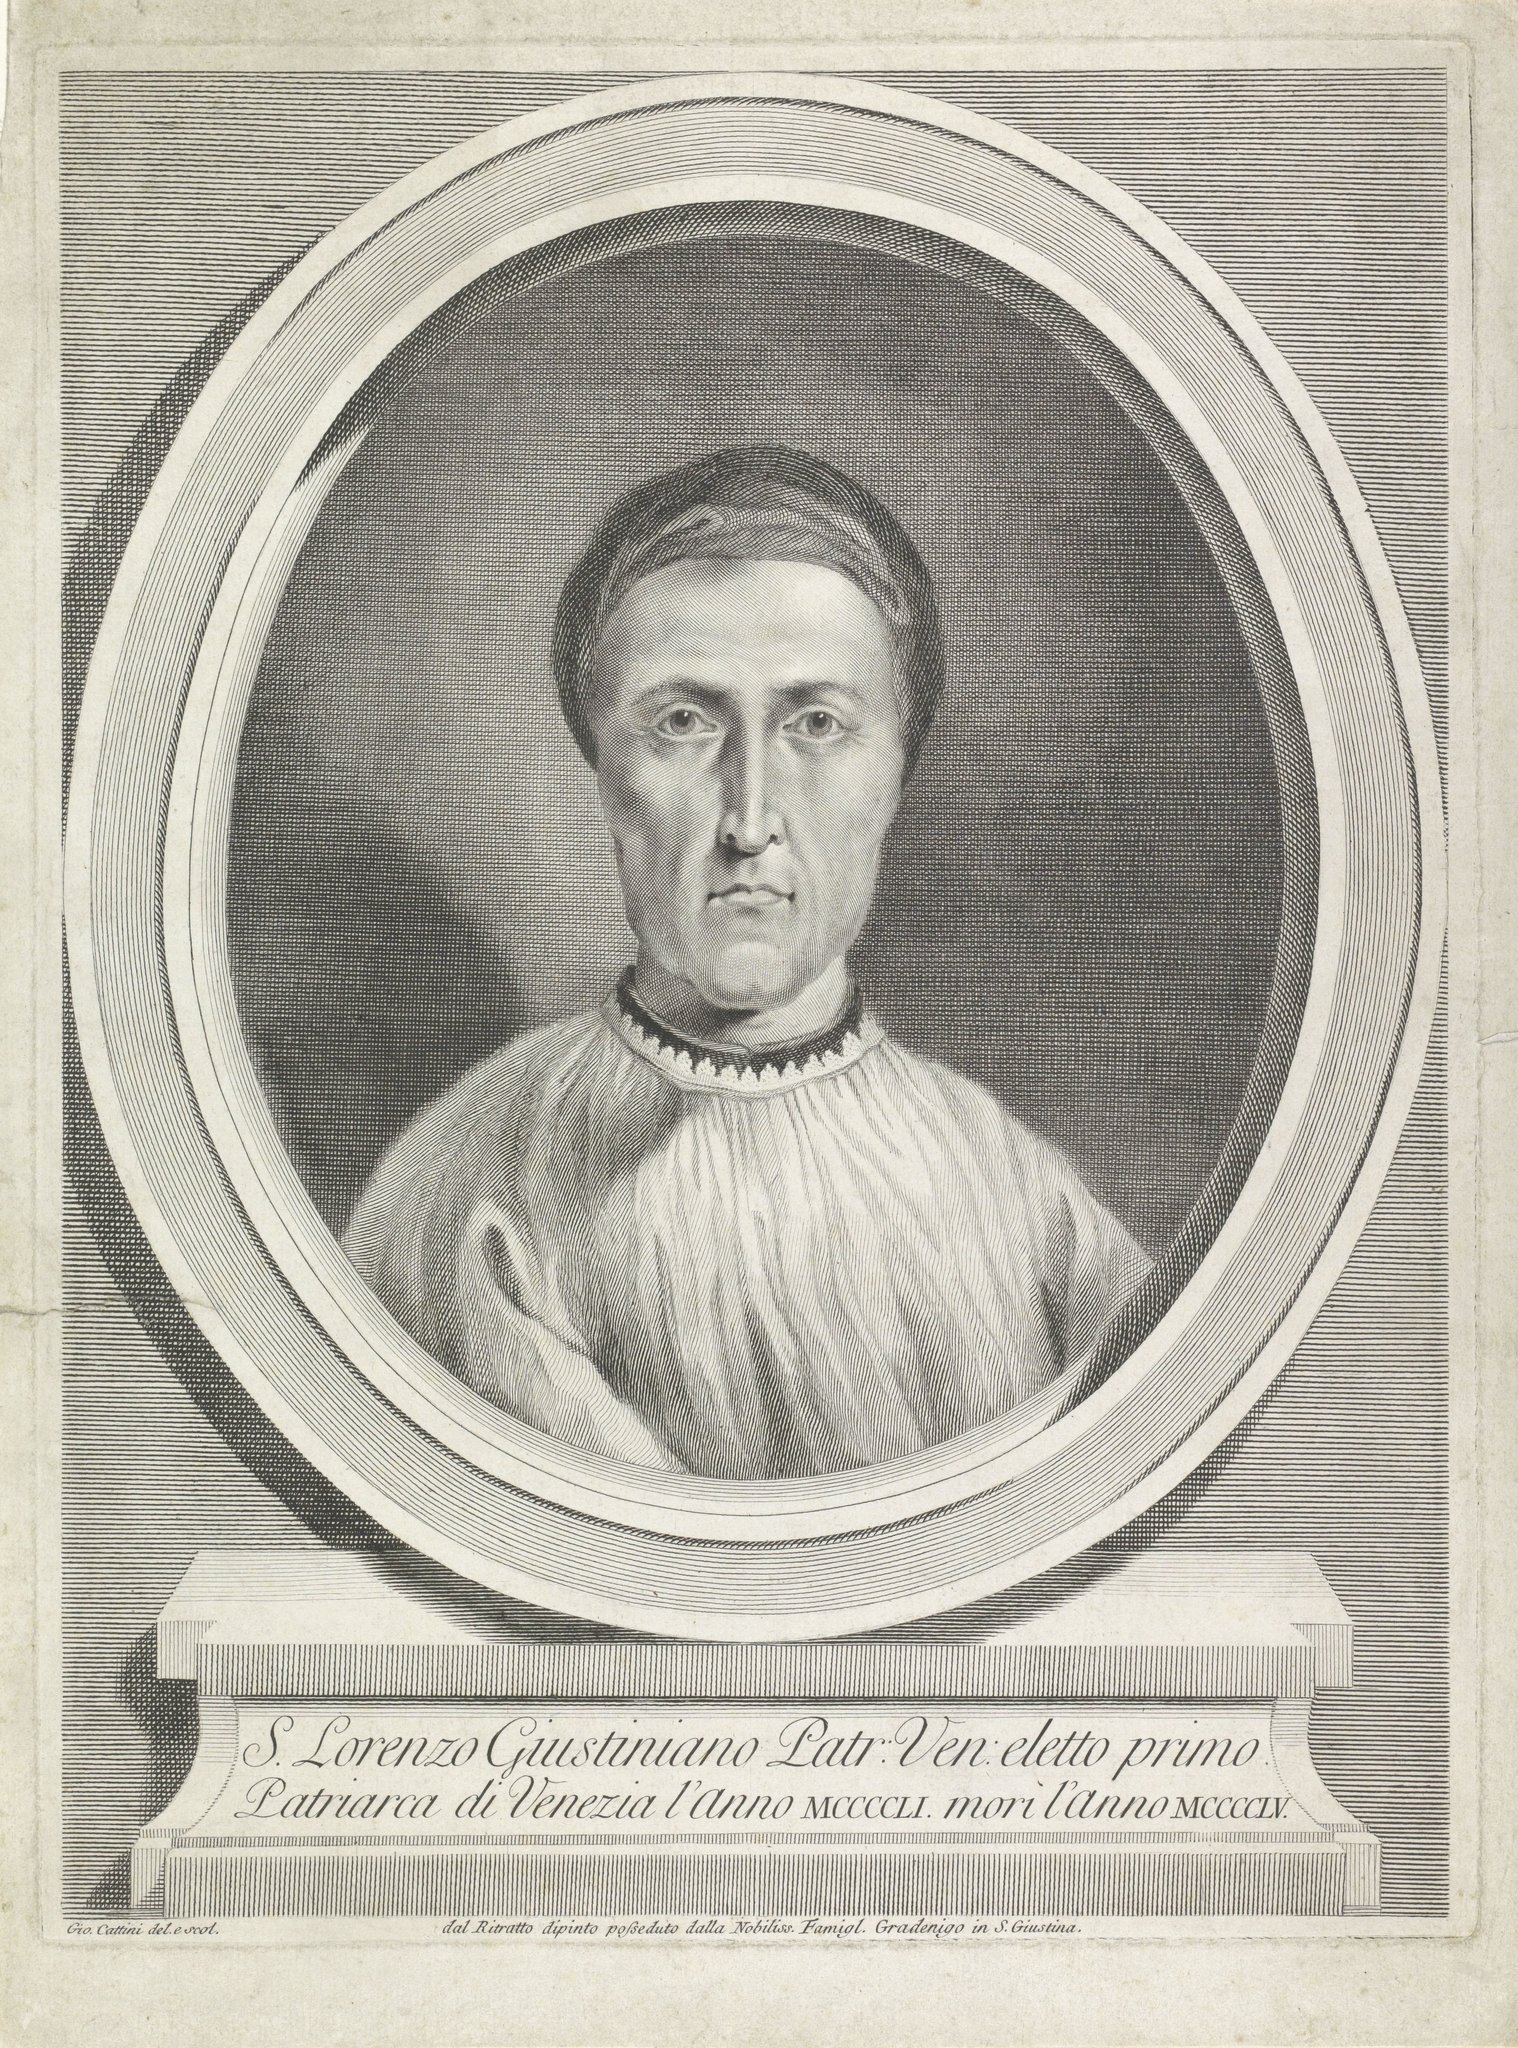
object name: print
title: Portret van Lorenzo Giustiniani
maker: giovanni cattini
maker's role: print maker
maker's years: 1725-1800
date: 1735-1800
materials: paper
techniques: engraving, etching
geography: italy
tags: venice, historical persons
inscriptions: collector's mark: Lugt 2228